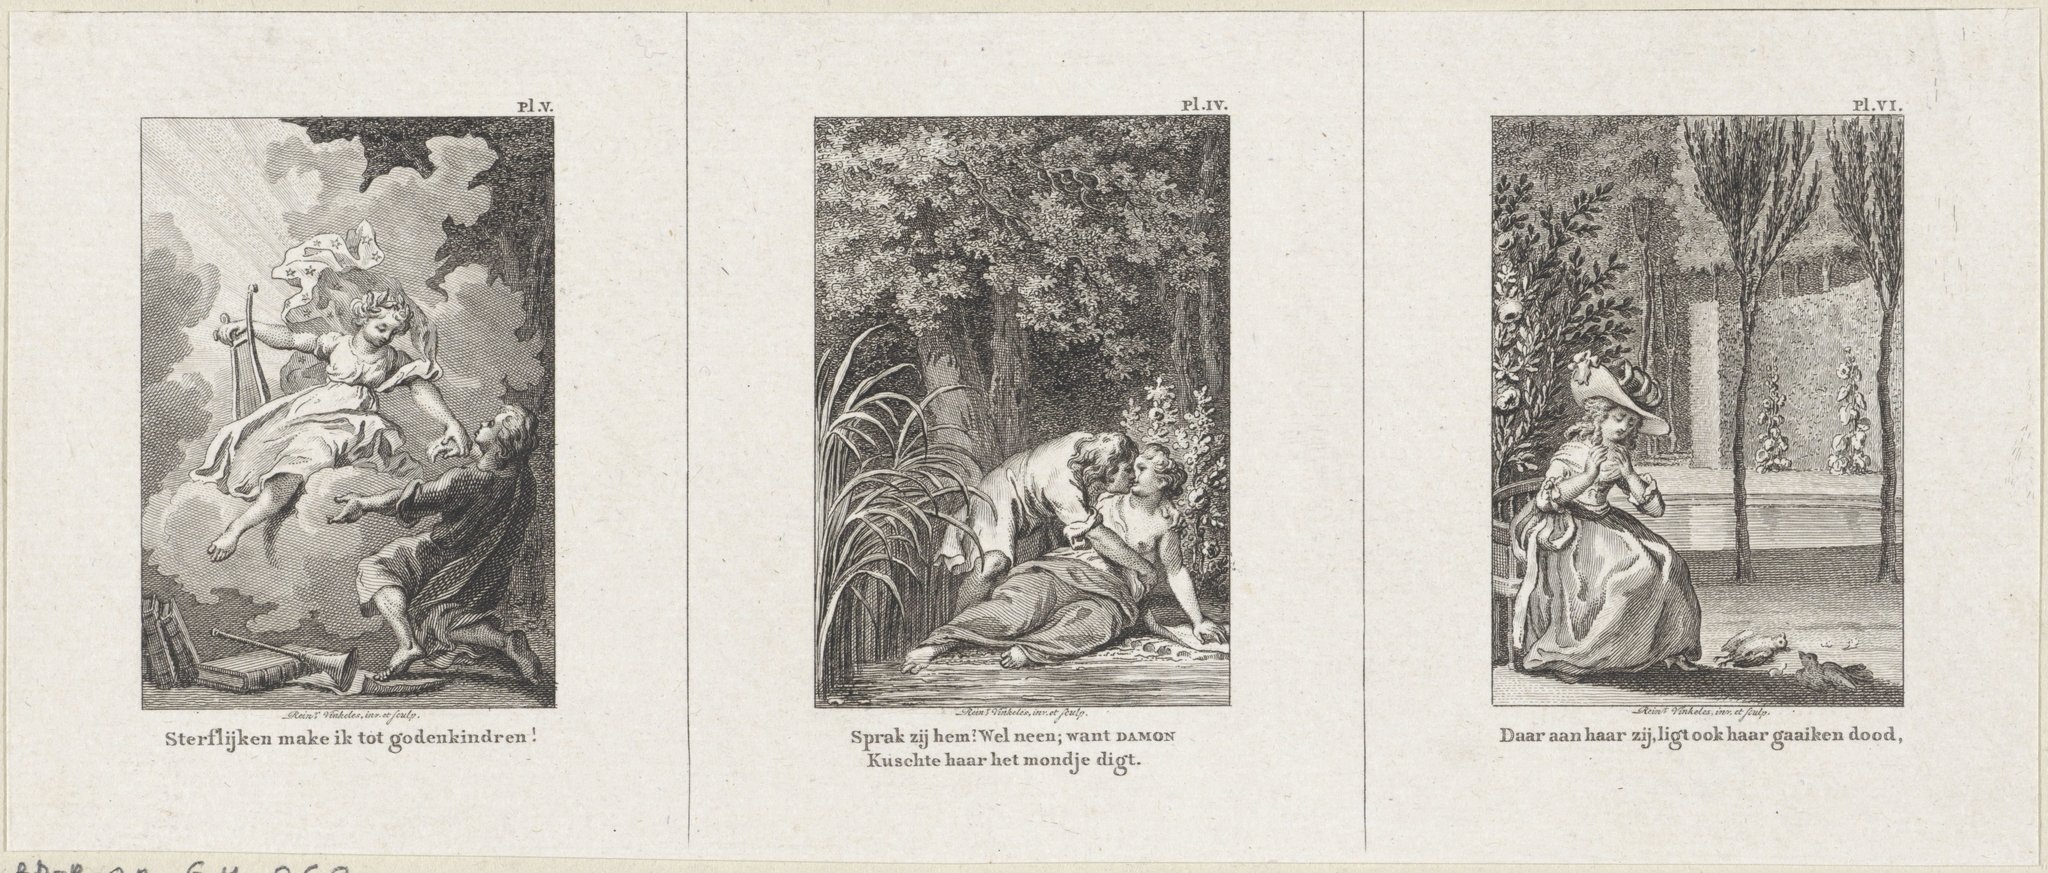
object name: print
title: Personificatie en een geknielde man /Kussend paar aan het water/ Vrouw bekijkt twee dode vogels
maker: reinier vinkeles (i)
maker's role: draughtsman, print maker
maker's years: 1741-1816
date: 1789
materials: paper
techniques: engraving, etching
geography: amsterdam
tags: clouds, birds, garden, (lovers) kissing each other, harp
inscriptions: collector's mark: Lugt 240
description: Illustraties voor: Almanach, voor jonge heeren en juffers. Amsterdam: Johannes Allart, 1789.